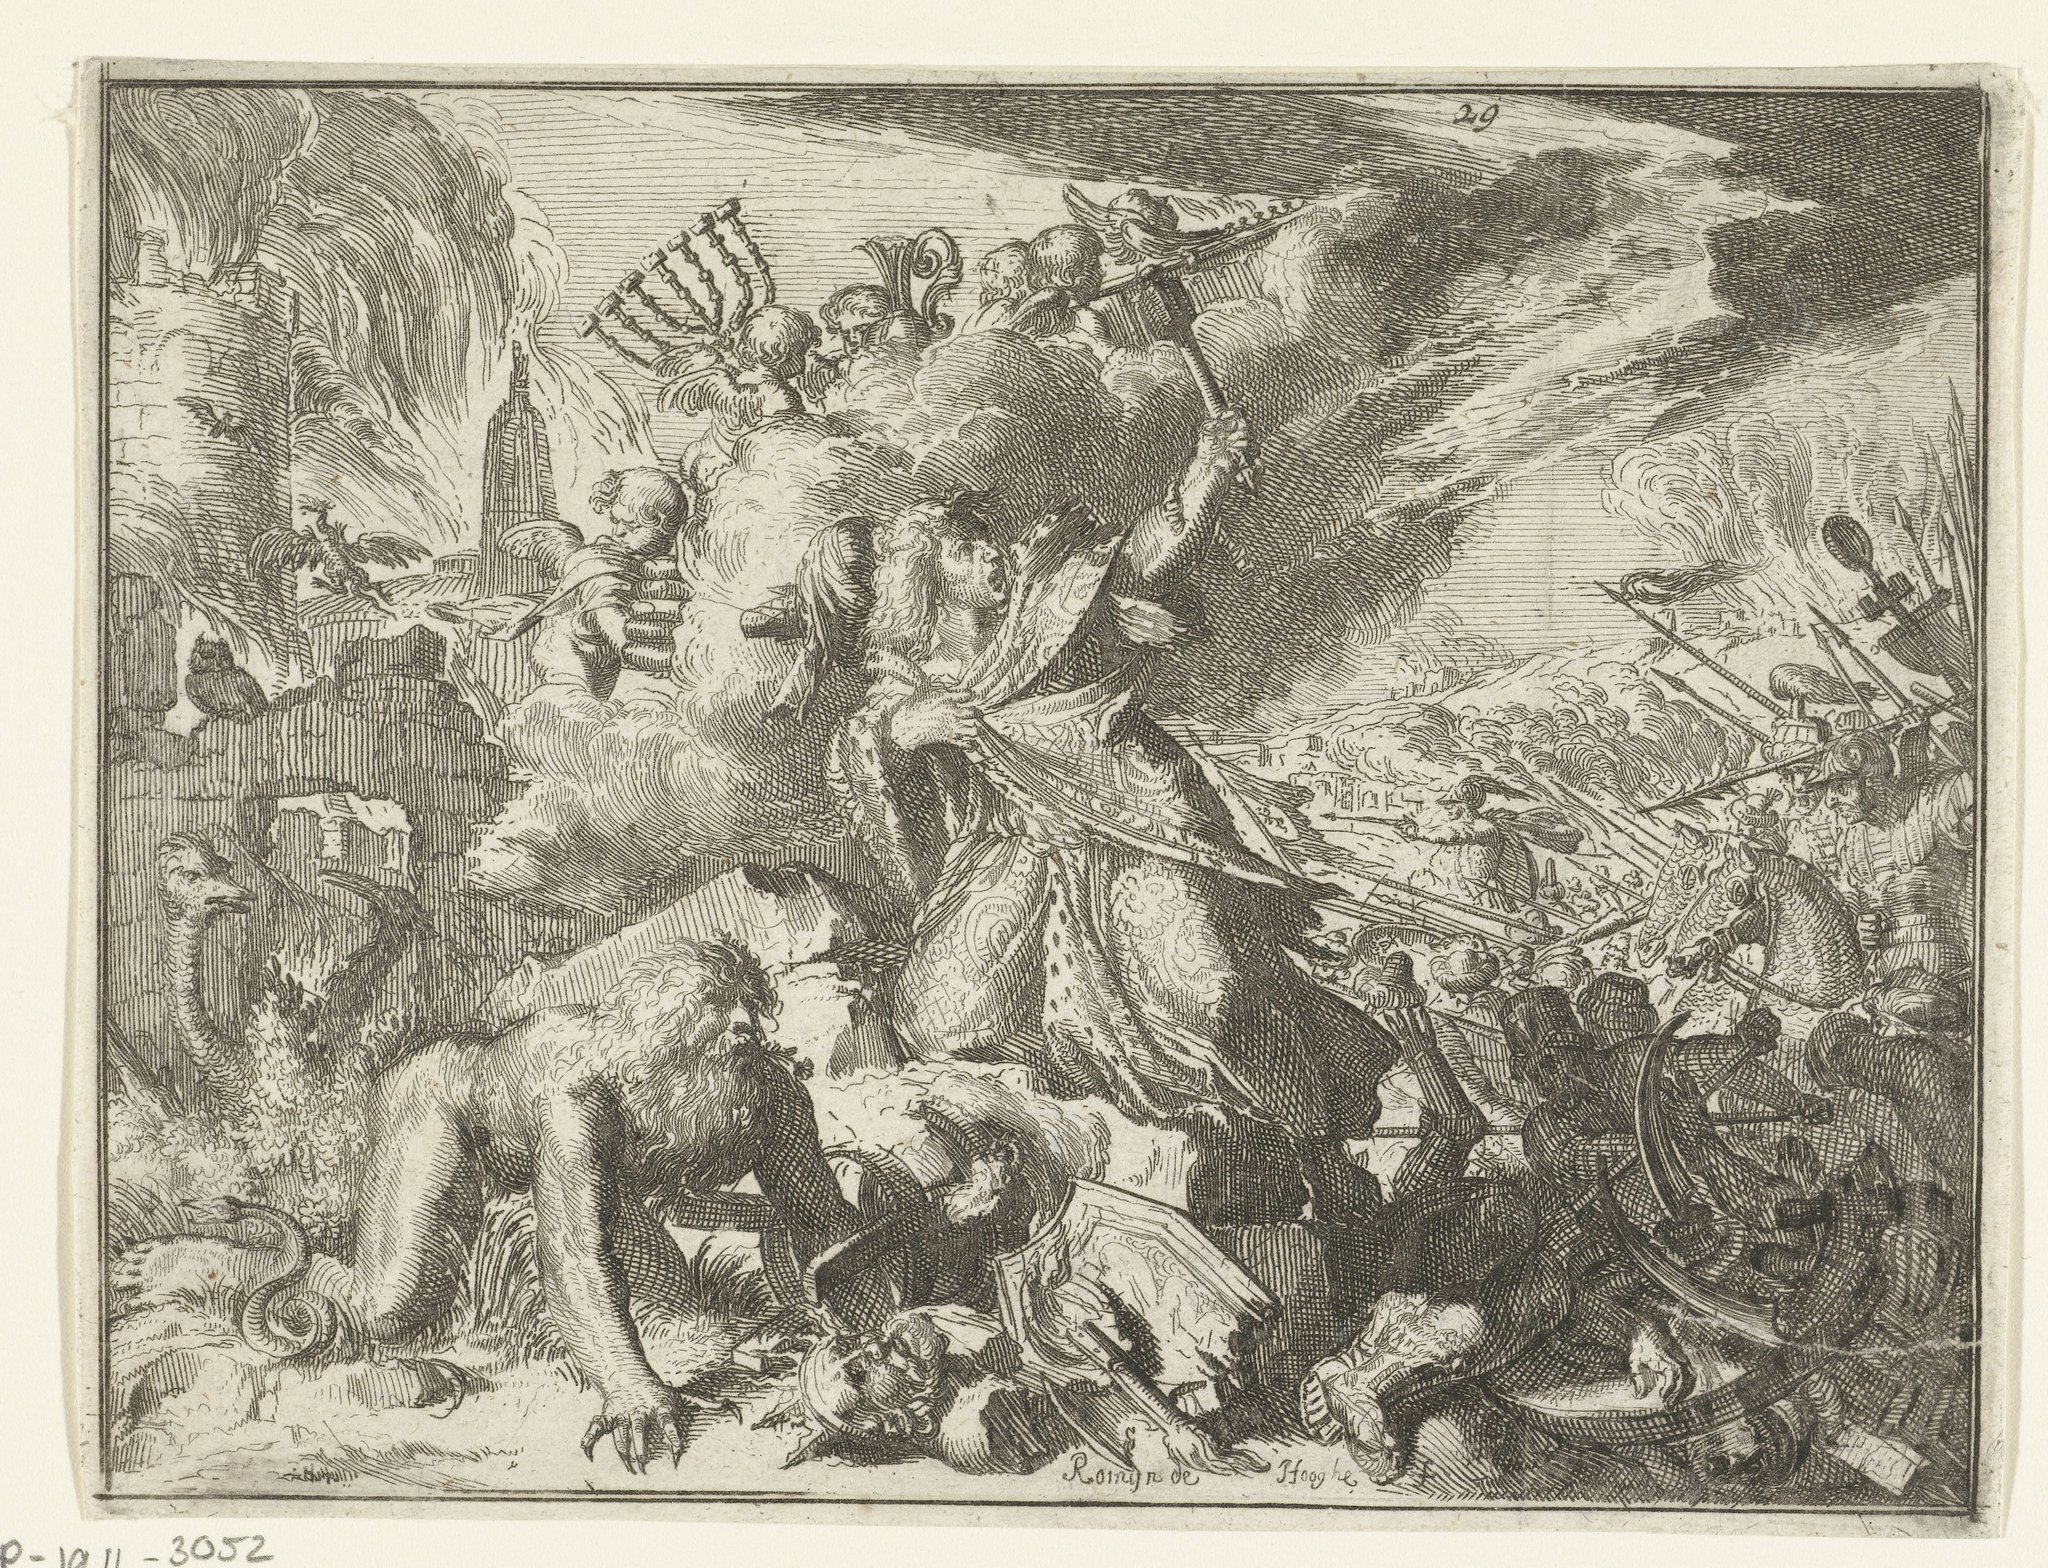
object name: print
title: Man gehuld in mantel wordt aangevallen door ruiters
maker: romeyn de hooghe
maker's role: draughtsman, goldsmith, painter, print maker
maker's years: 1645-1708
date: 1655-1708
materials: paper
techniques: engraving, etching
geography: netherlands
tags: on fire, ablaze, wild man, wodewose, woodehouse, battle, fighting in general, cupids: 'amores', 'amoretti', 'putti'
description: Man met mantel en tulband wordt aangevallen door ruiters. In de lucht putti met vaatwerk en kandelaar. Linksvoor een kruipende wildeman. Links op achtergrond brandende stad.